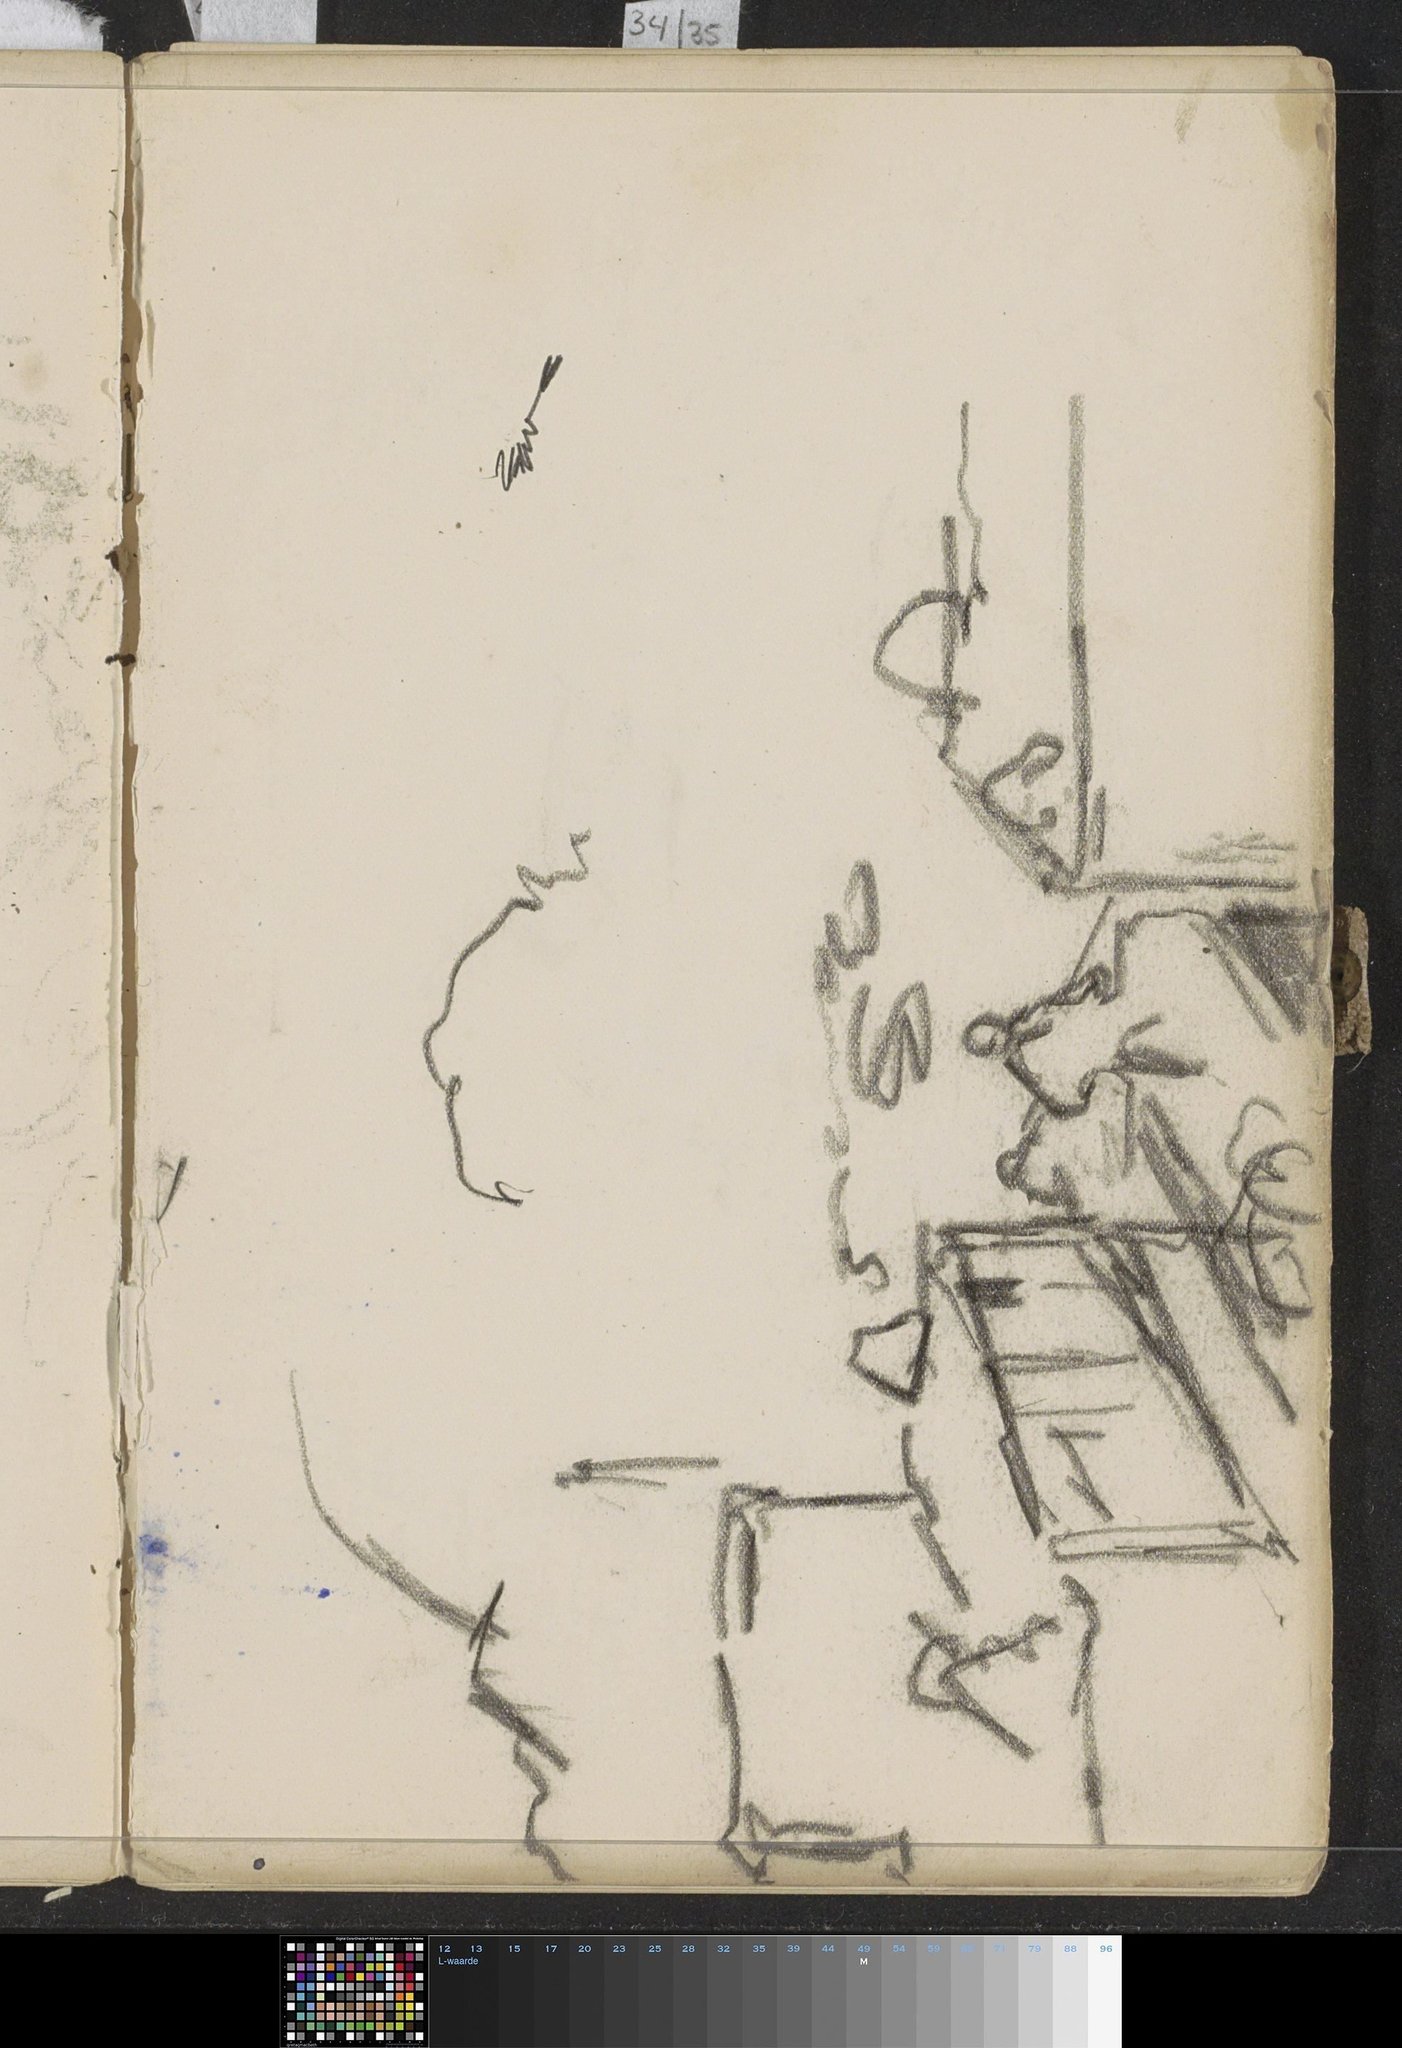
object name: sketchbook leaf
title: Huizen en figuren aan een kade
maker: cornelis vreedenburgh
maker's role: draughtsman, print maker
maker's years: 1880-1946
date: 1890-1946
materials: chalk, paper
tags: quay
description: Blad 31 recto uit een schetsboek met 47 bladen.